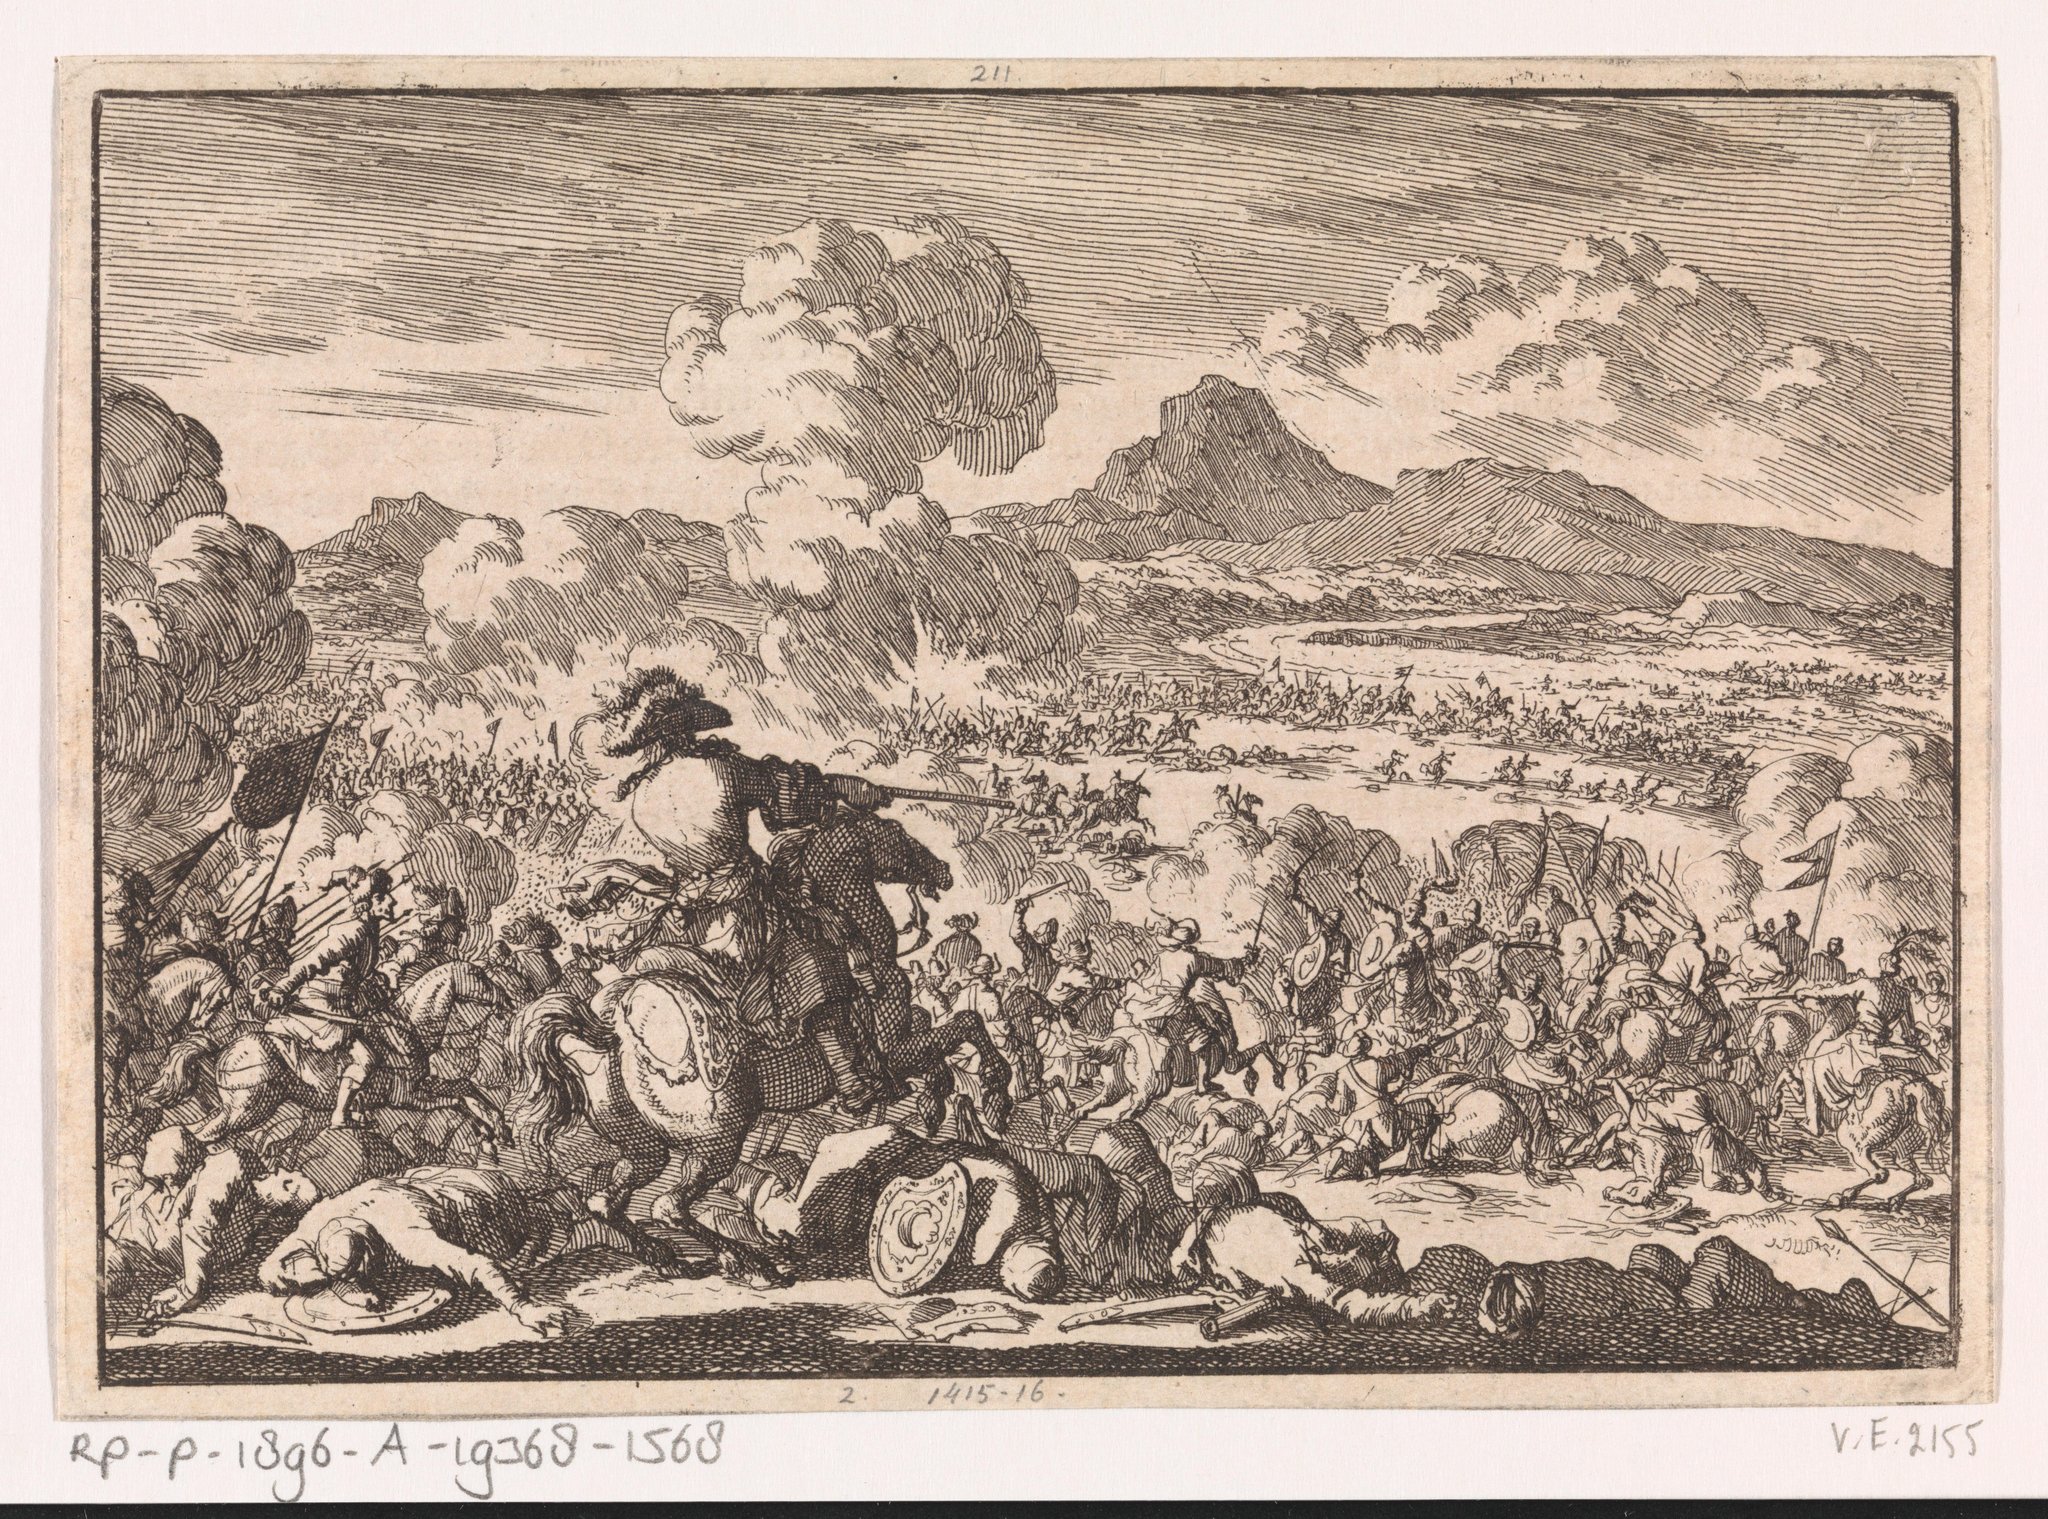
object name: book illustration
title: Overwinning van prins Eugenius op de Turken aan de Tisza, 1697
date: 1698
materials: paper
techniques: etching, letterpress printing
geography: amsterdam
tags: paris, vienna, eugenius van savoye, victory ~ armed conflict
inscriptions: collector's mark: Lugt 2228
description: Illustratie uit: Gottfried, Johann Ludwig. Historische kronyck; vervattende een (...) beschrijvingh der aldergedenckwaerdigste geschiedenissen des weerelds, van den aenvangh der scheppingh tot (...) 1576 (2 delen). Leiden: Pieter van der Aa, 1698, dl. II, p. 1415.